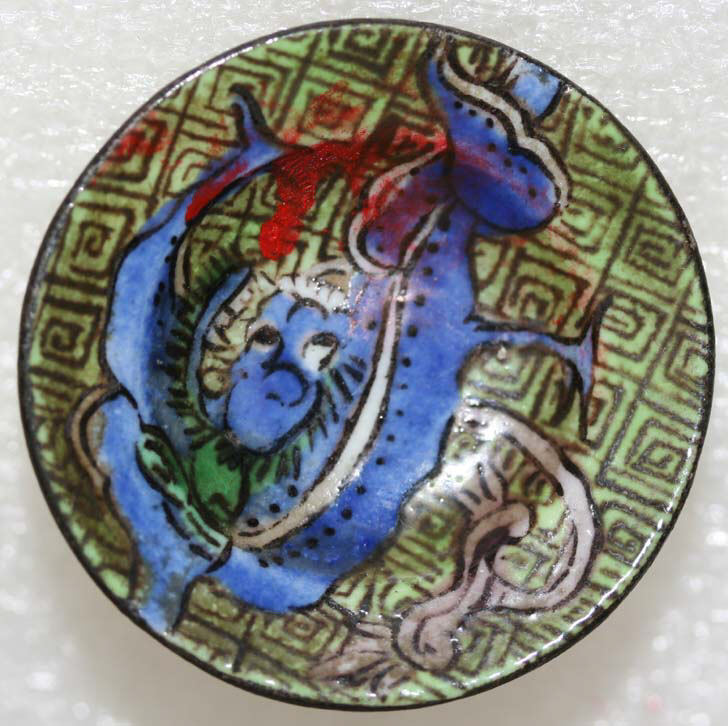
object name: button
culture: chinese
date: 249-210 BCE